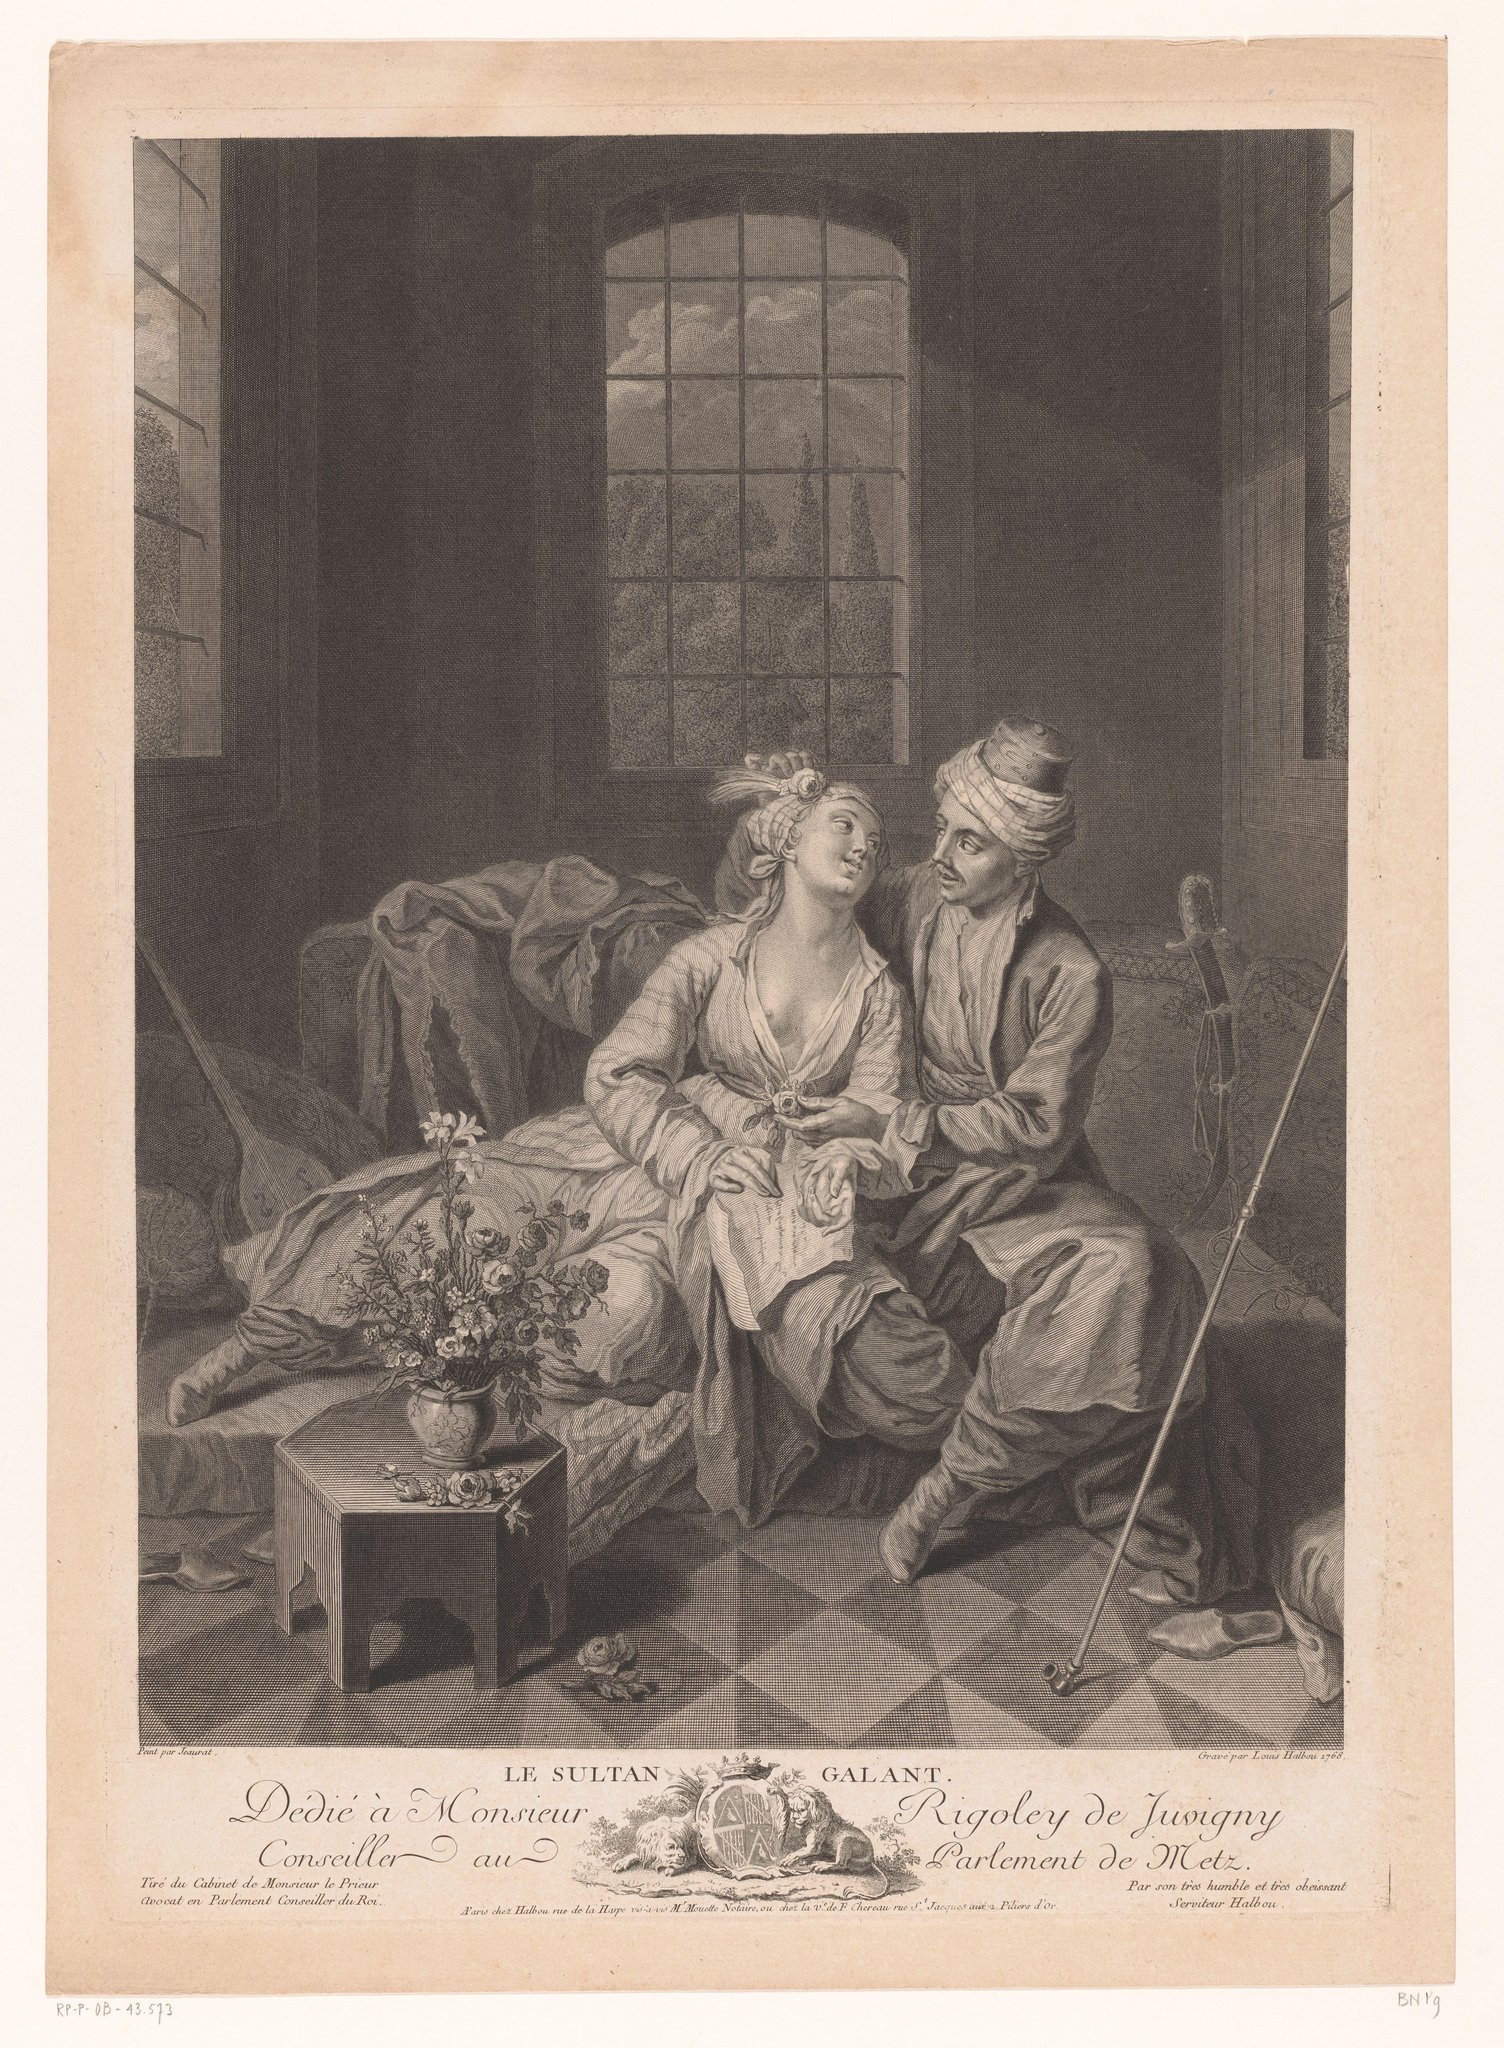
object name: print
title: Twee geliefden in een interieur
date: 1768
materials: paper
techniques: engraving, etching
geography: paris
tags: breasts, asiatic races and peoples: turks, head-gear: turban, lovers' meeting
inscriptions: collector's mark: Lugt 2228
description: Oosters interieur met een vrouw met ontblote borst naast een man met een fez.